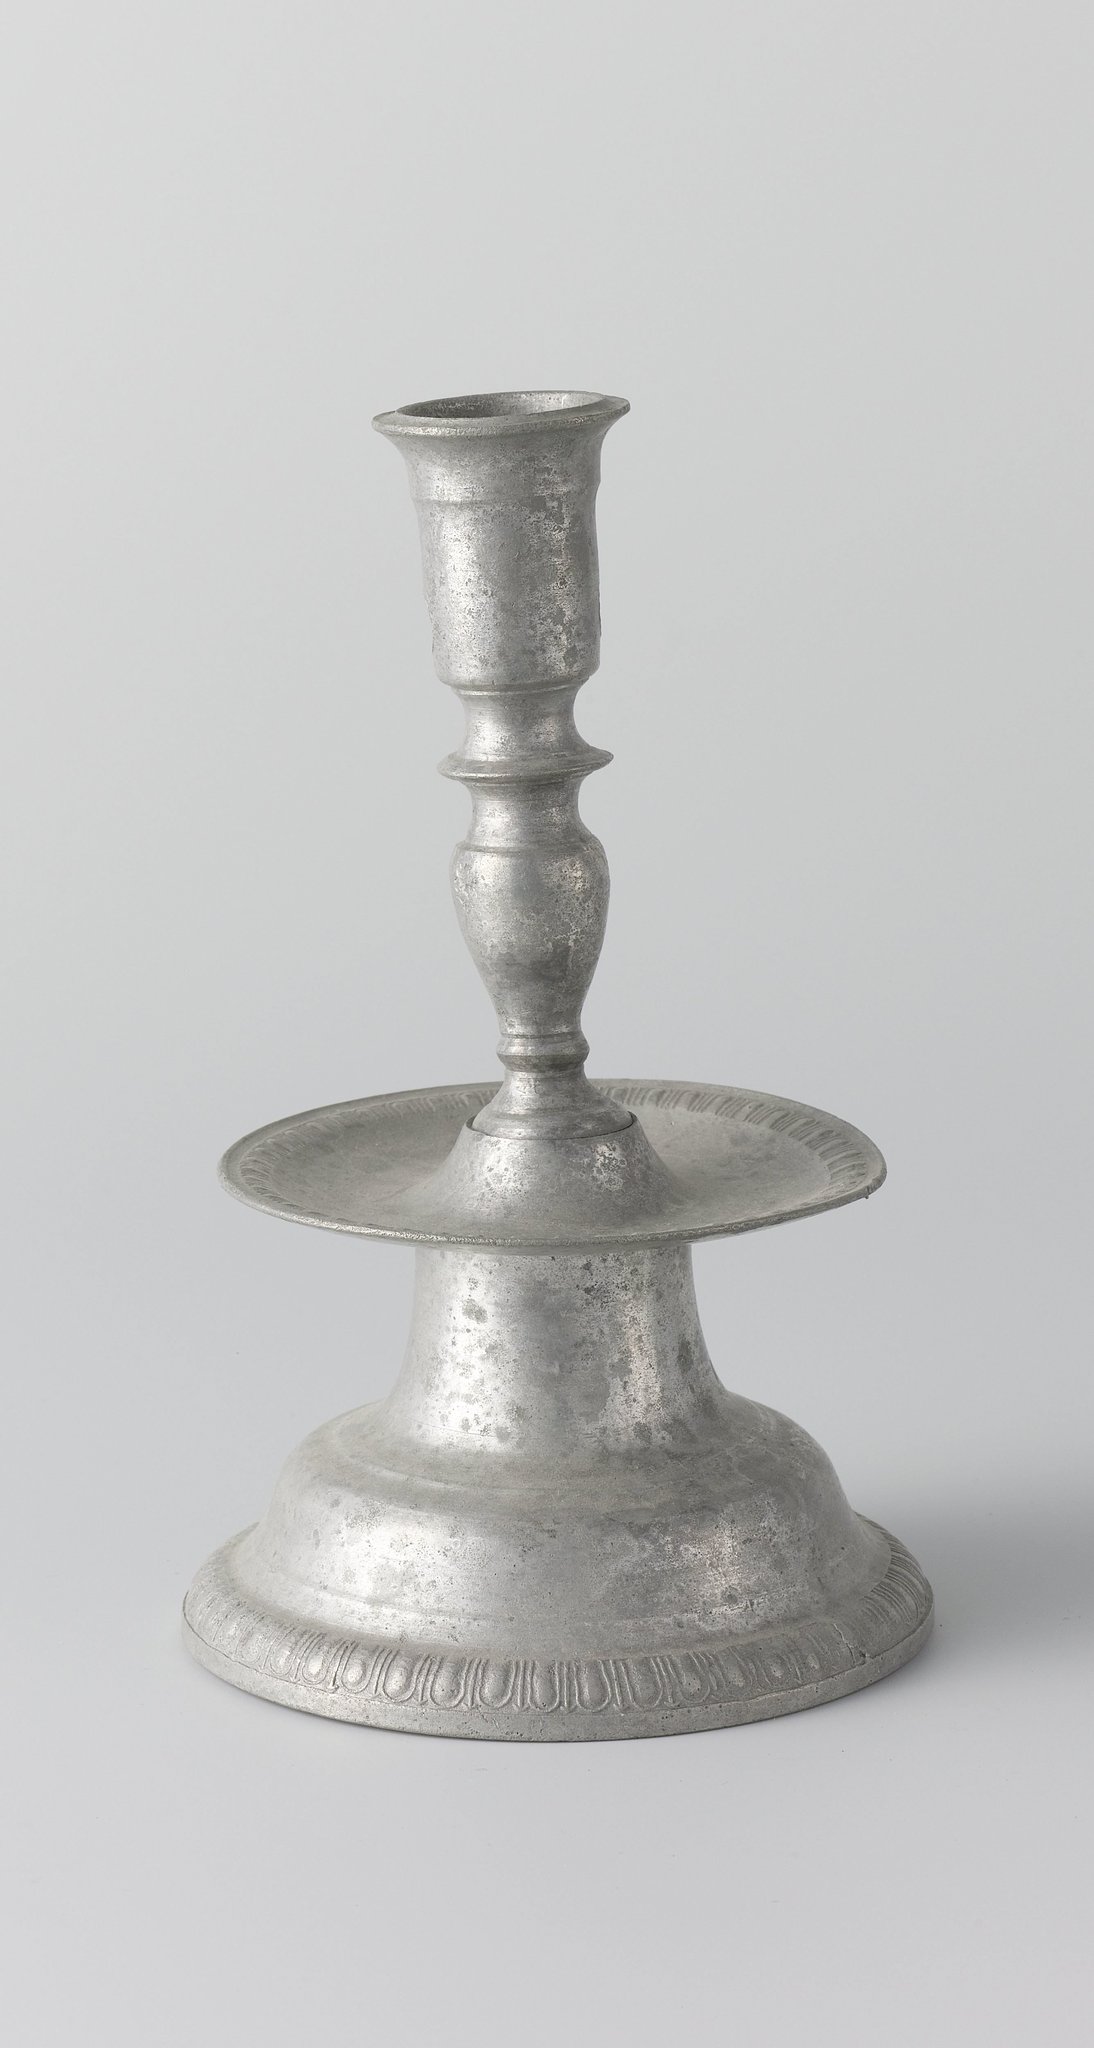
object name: flambouwkandelaar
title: Merchandise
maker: Anonymous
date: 1590-1596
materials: tin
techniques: casting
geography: netherlands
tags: willem barendsz., amsterdam, jacob van heemskerck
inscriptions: mark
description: Barentsz and his crew were en route to China, and therefore brought along goods they could use to conduct trade there. They obviously expected these pewter candlesticks to be in demand in Asia.